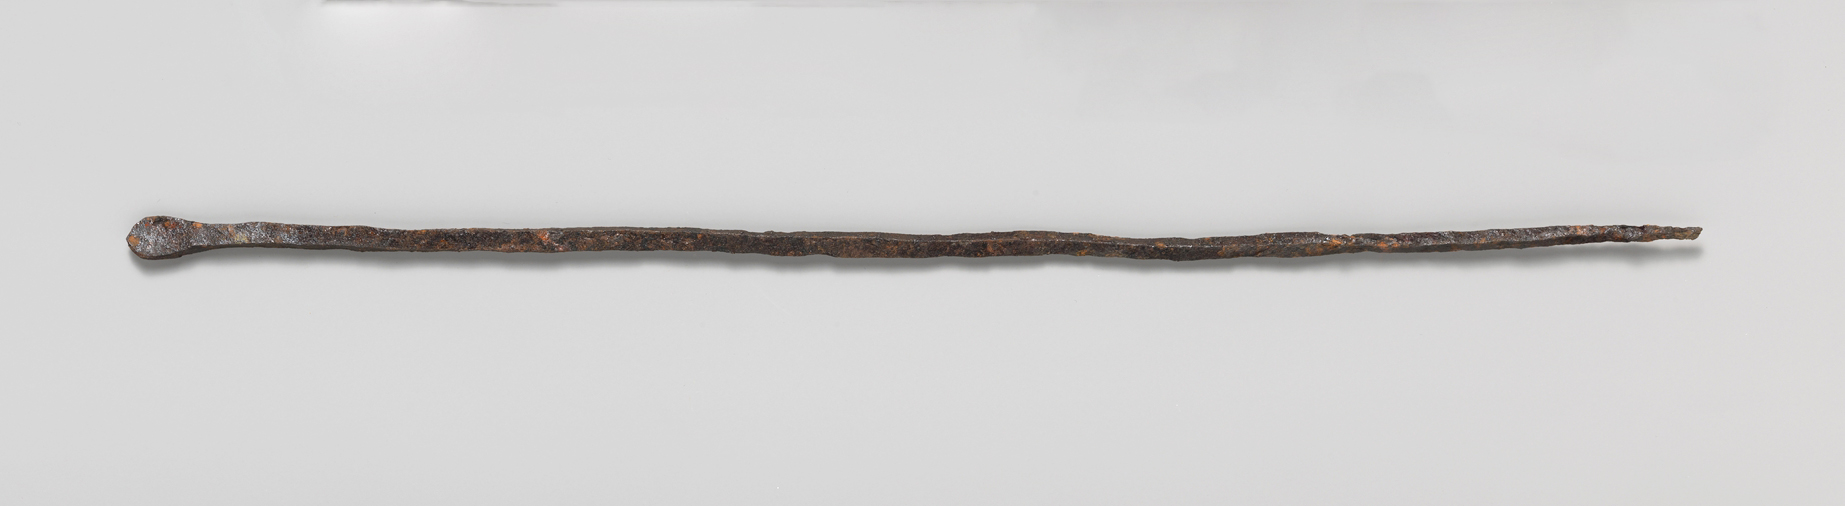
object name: spit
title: Iron spit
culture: etruscan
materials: iron